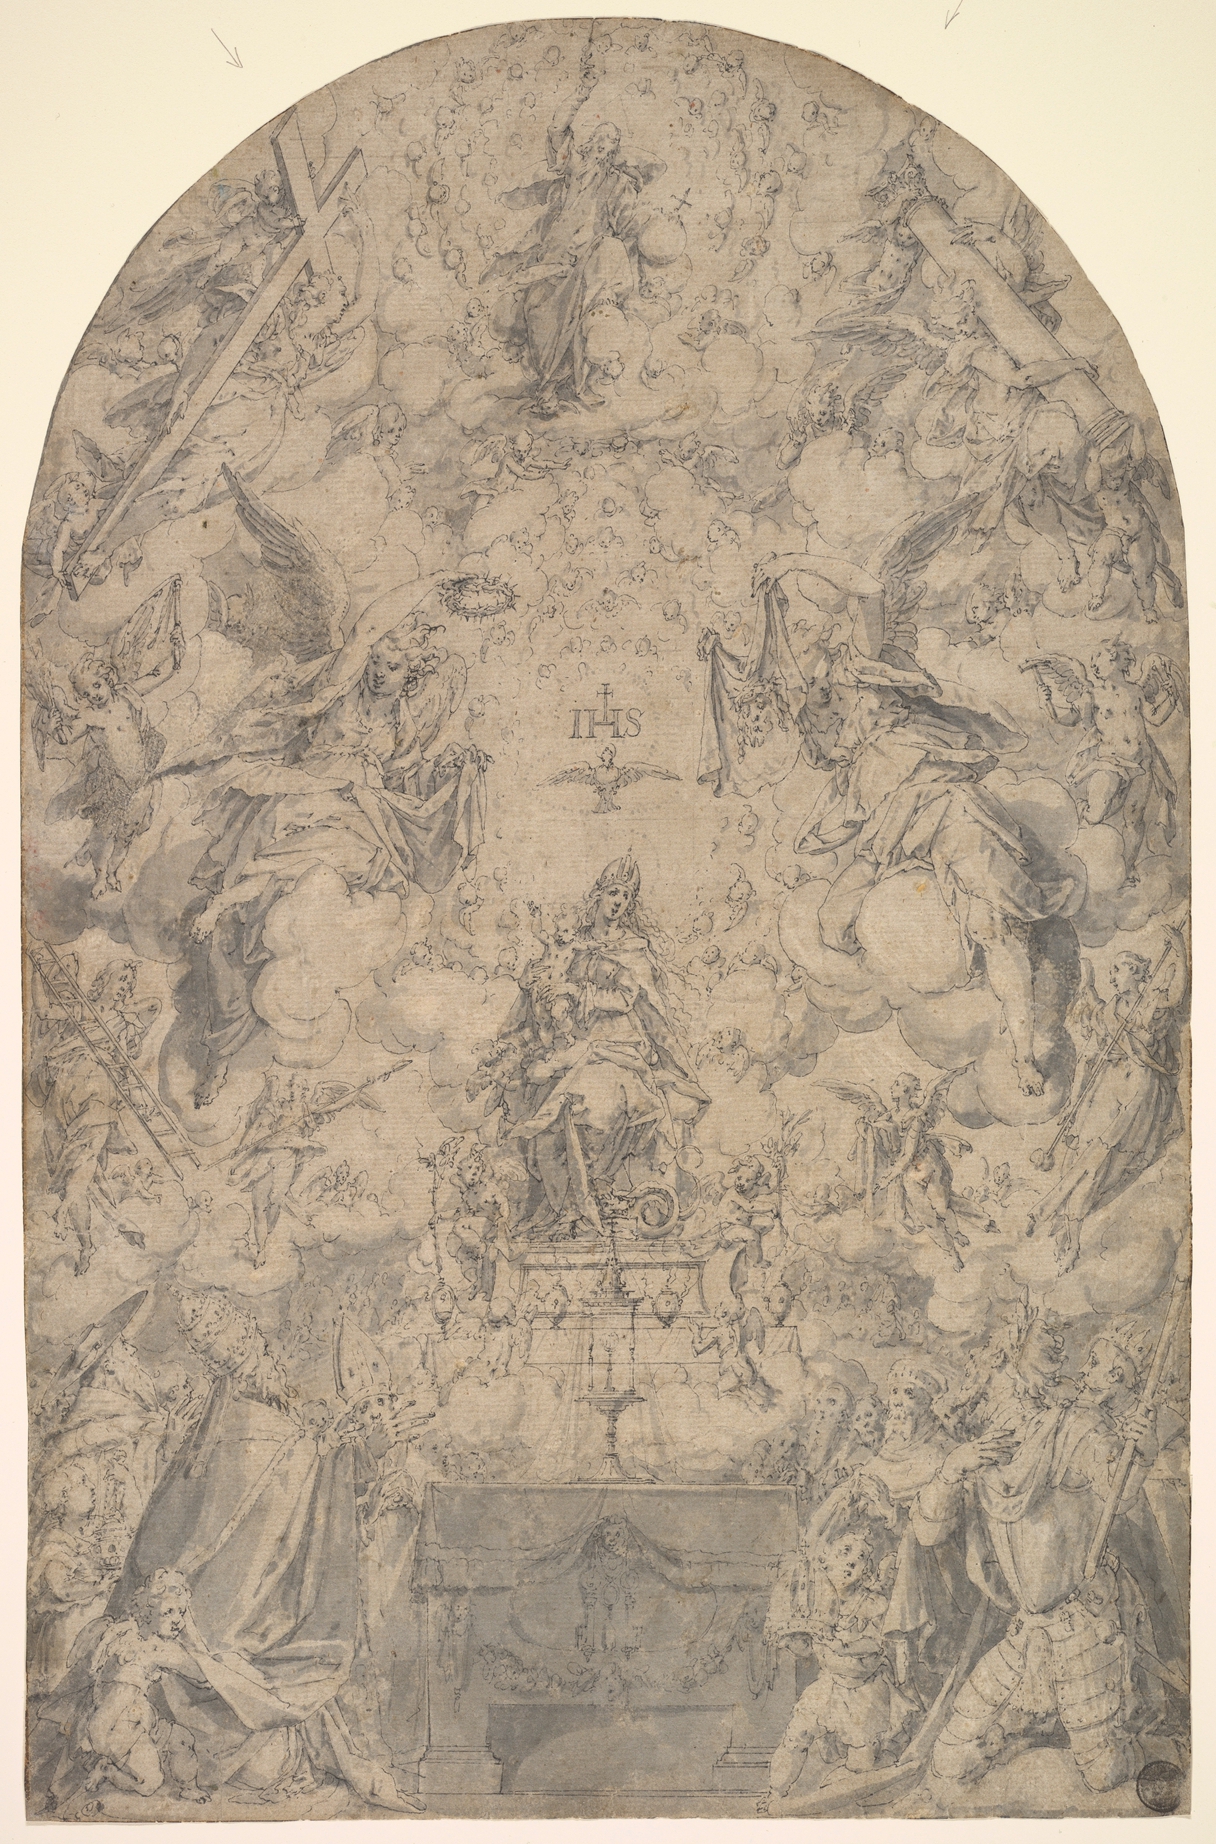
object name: drawing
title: The Adoration of the Holy Trinity in the New Covenant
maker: friedrich sustris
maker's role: artist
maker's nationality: netherlandish, born italy (?)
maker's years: 1535-1599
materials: ink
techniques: pen, wash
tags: virgin mary,cross